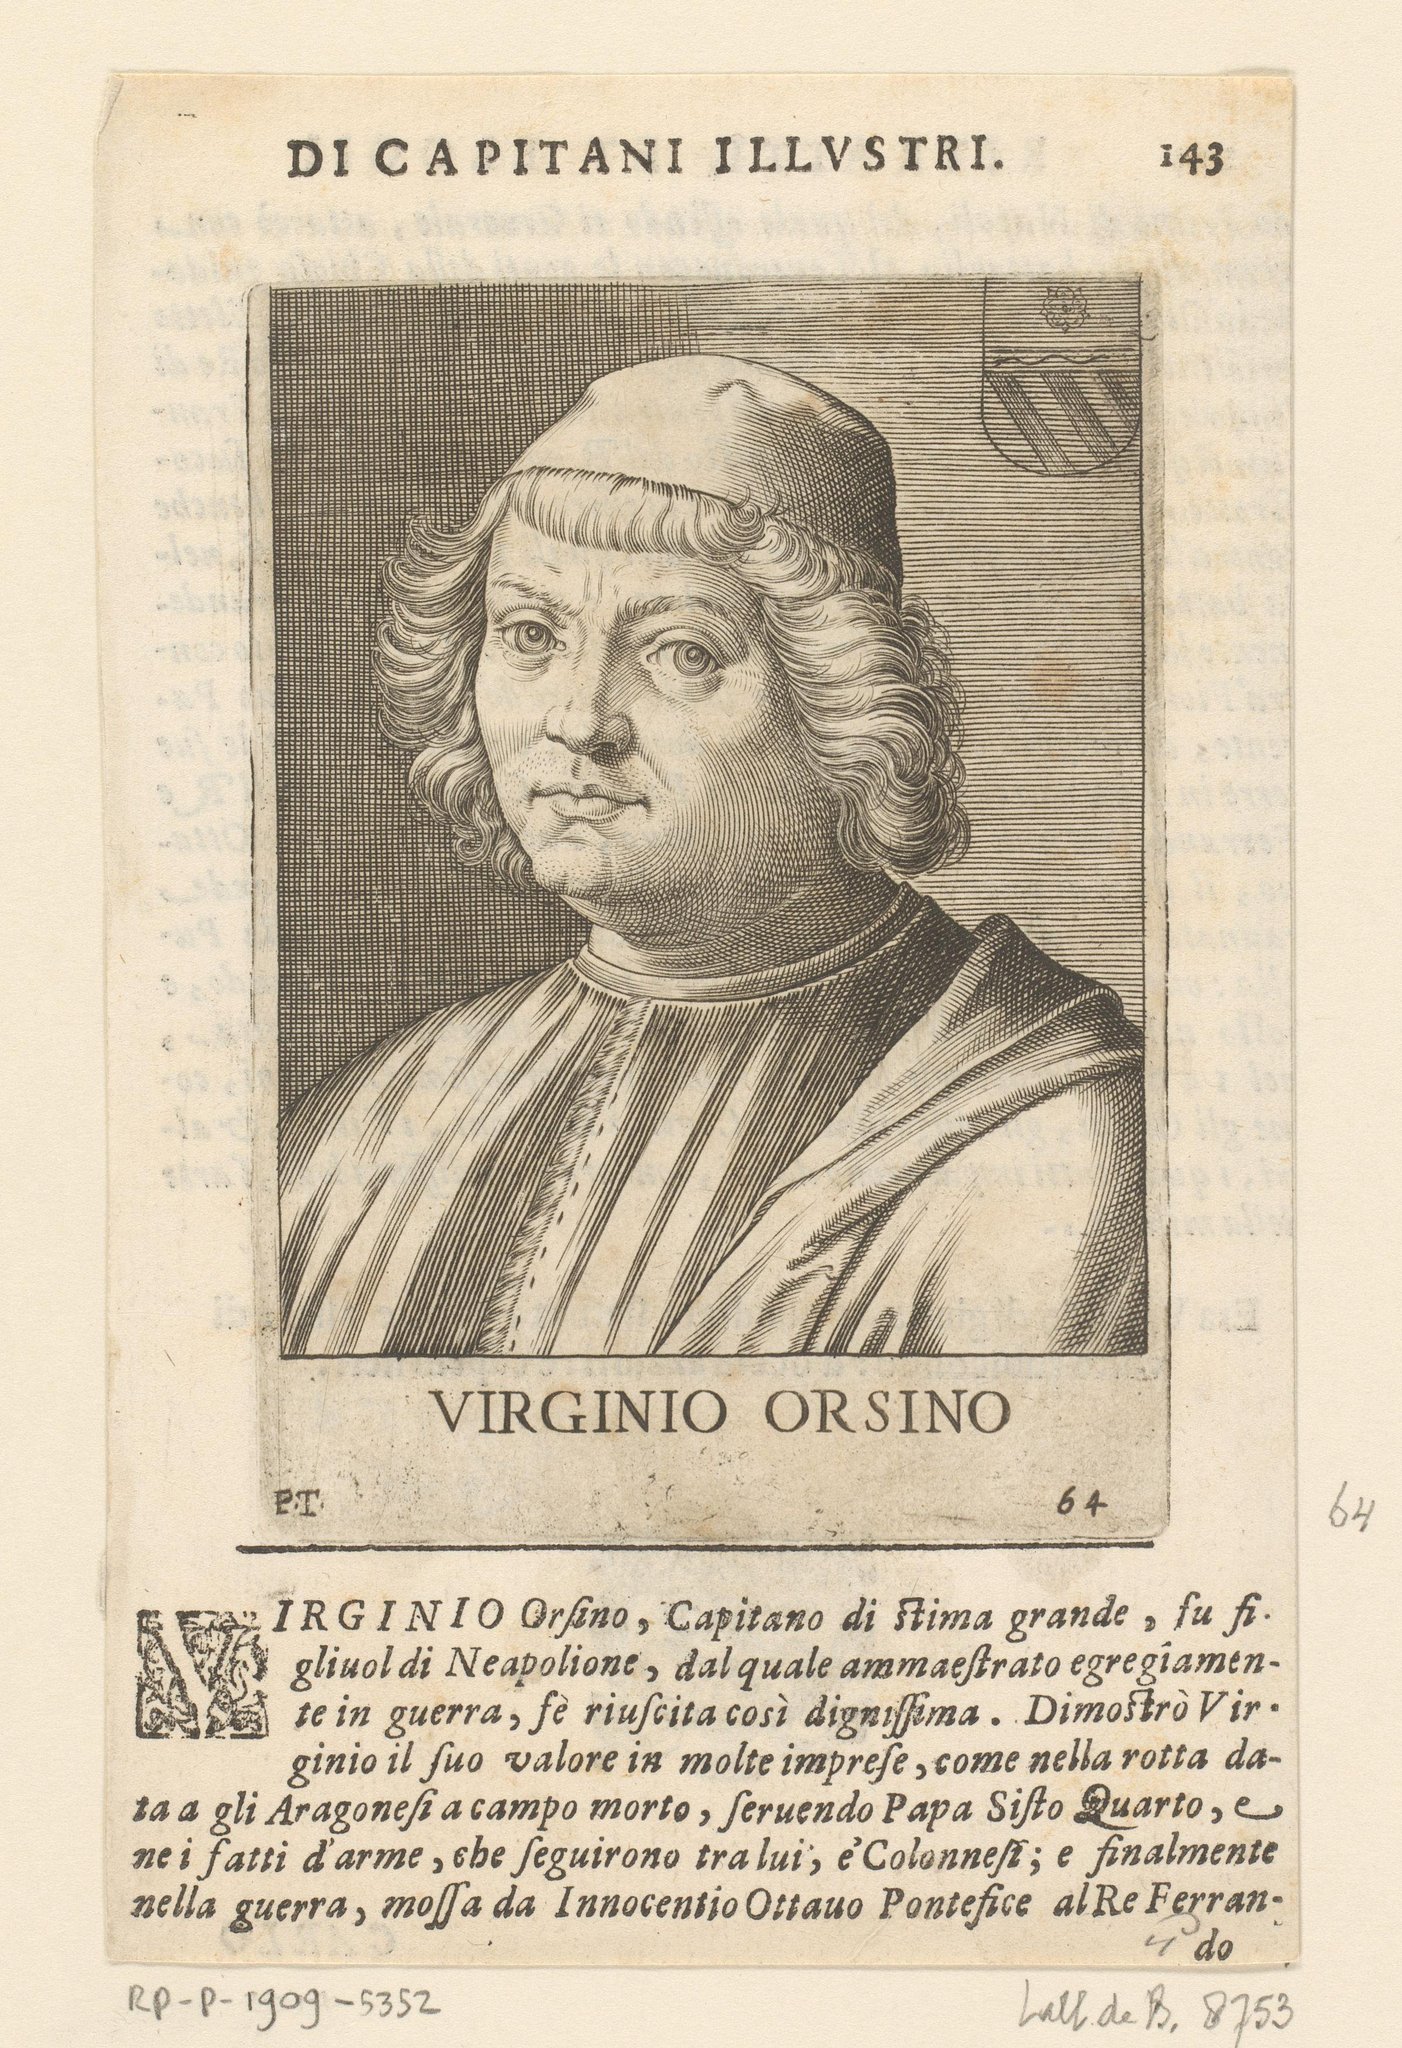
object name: print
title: Portret van legeraanvoerder Gentile Virginio Orsini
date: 1635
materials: paper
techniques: engraving, letterpress printing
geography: rome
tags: naples, commander-in-chief, general, marshal, historical persons, armorial bearing, heraldry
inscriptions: collector's mark: Lugt 2228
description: Prent uit: Ritratti et elogii di capitani Illustri. Rome: Pompilio Totti en Andrea Fei, 1635, p. 143. Eerdere staat van prent in ieder geval ook gebruikt in: Ritratti di cento capitani illustri con li lor Fatti in guerra (…), Rome: Domenico Gigliotti, 1596. Latere staat van prent in ieder geval ook gebruikt in: Ritratti et elogii di capitani Illustri. Che ne'secoli moderni hanno gloriosamente guerreggiato. Rome: Filippo de'Rossi en Vitale Mascardi, 1646.